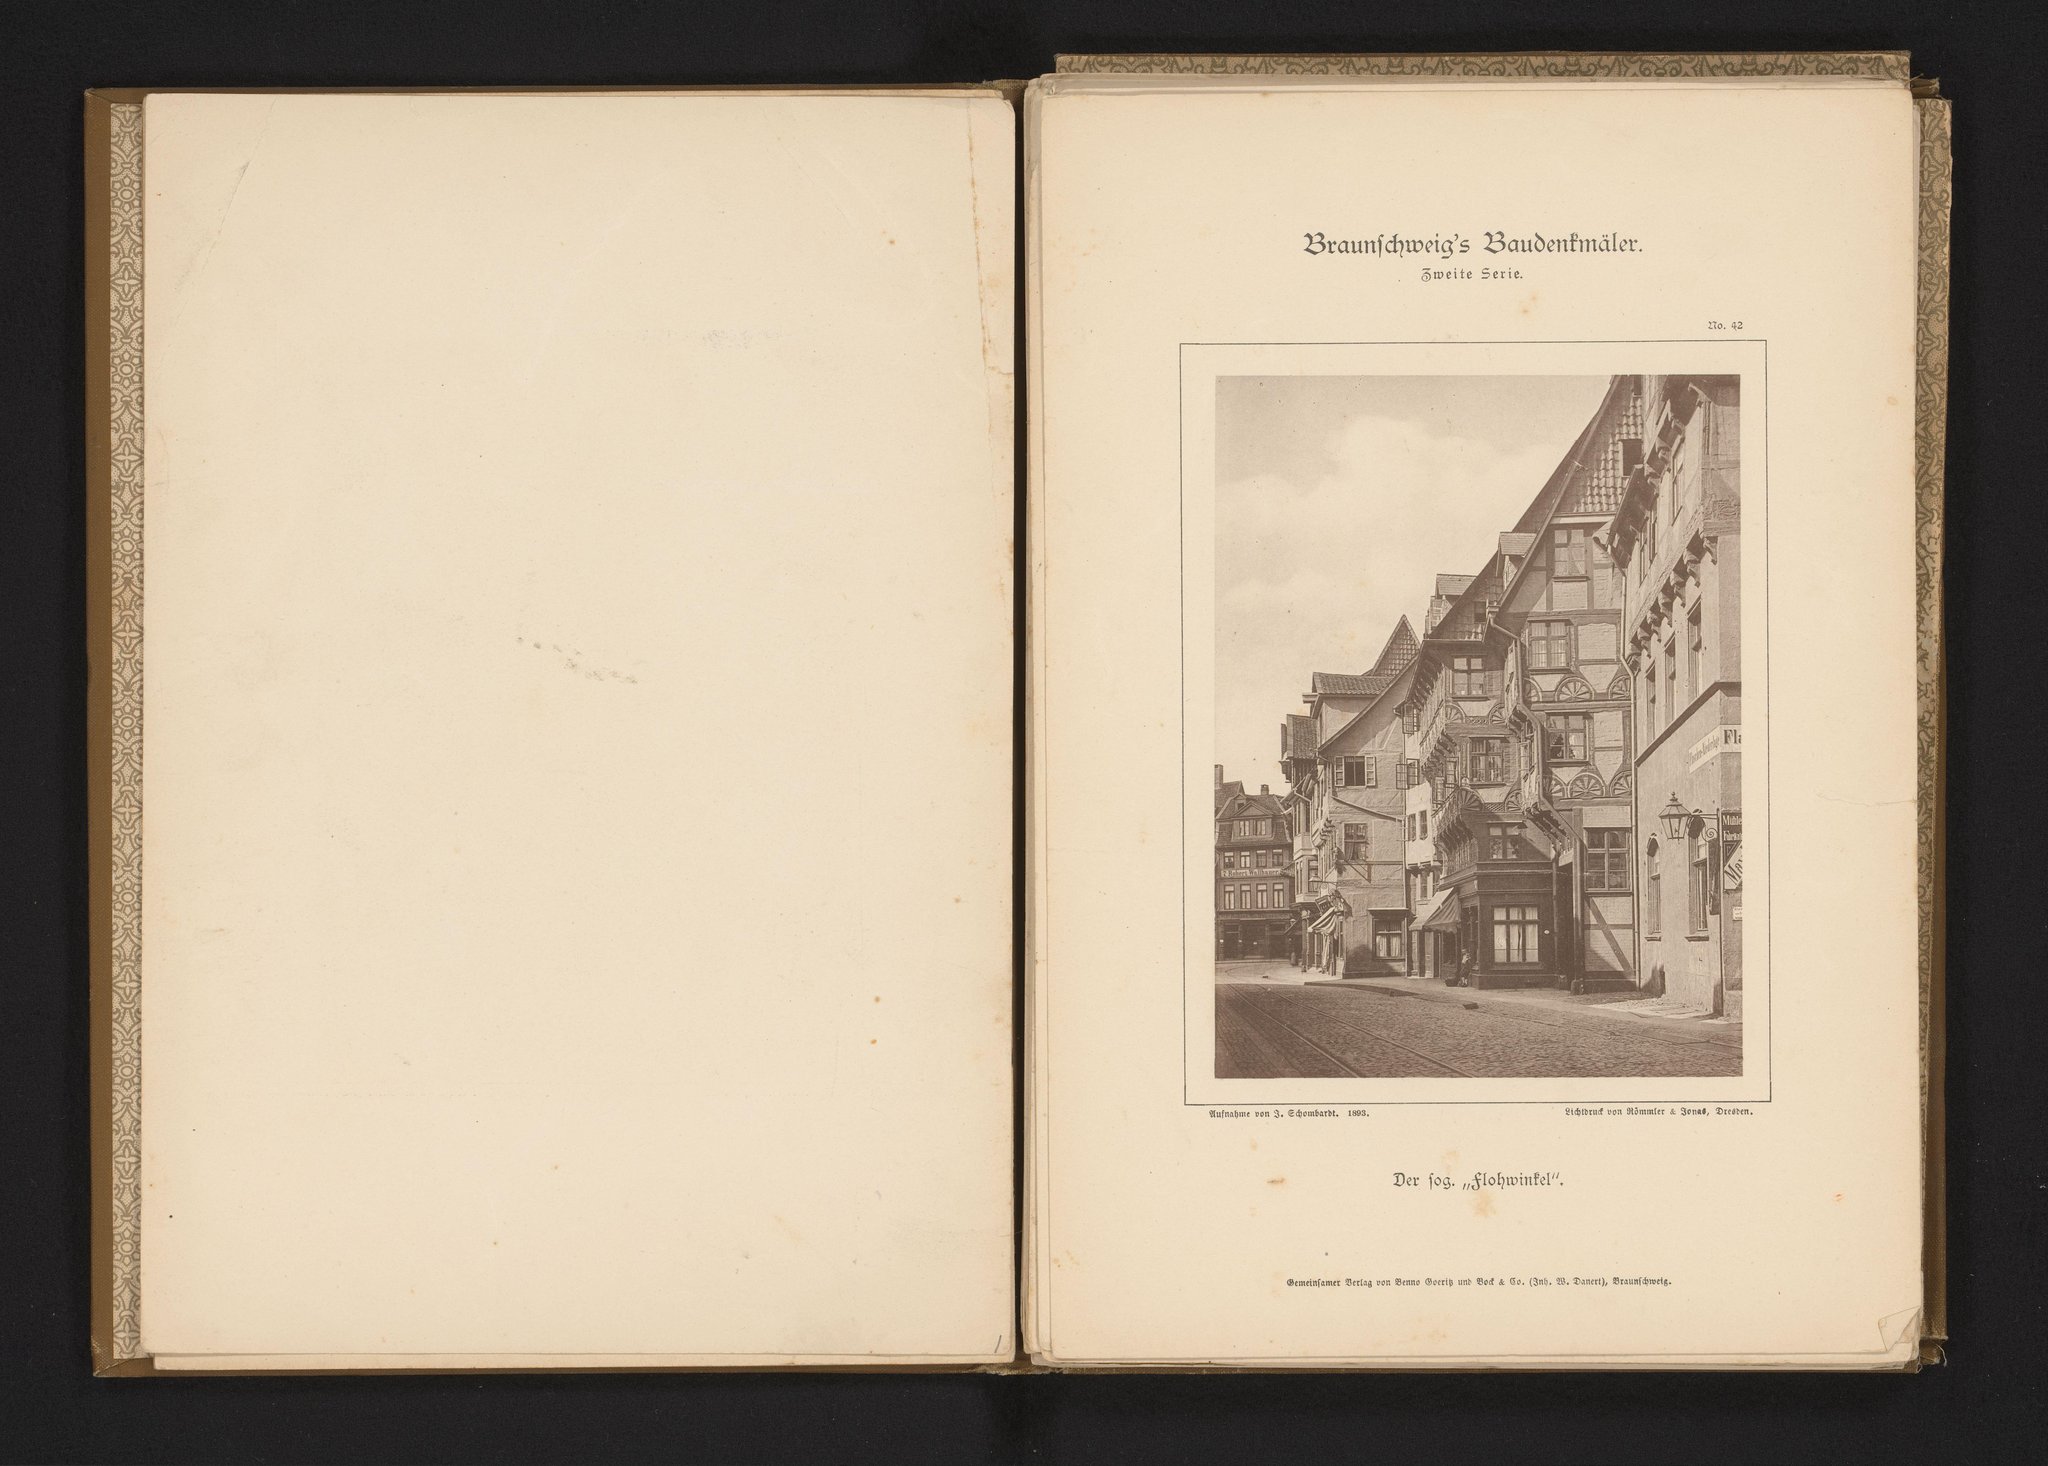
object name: photomechanical print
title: Der sog. ,,Flohwinkel"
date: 1893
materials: paper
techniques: photograph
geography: braunschweig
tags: shop, store, façade (of house or building)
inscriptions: number: ‘No. 42.’